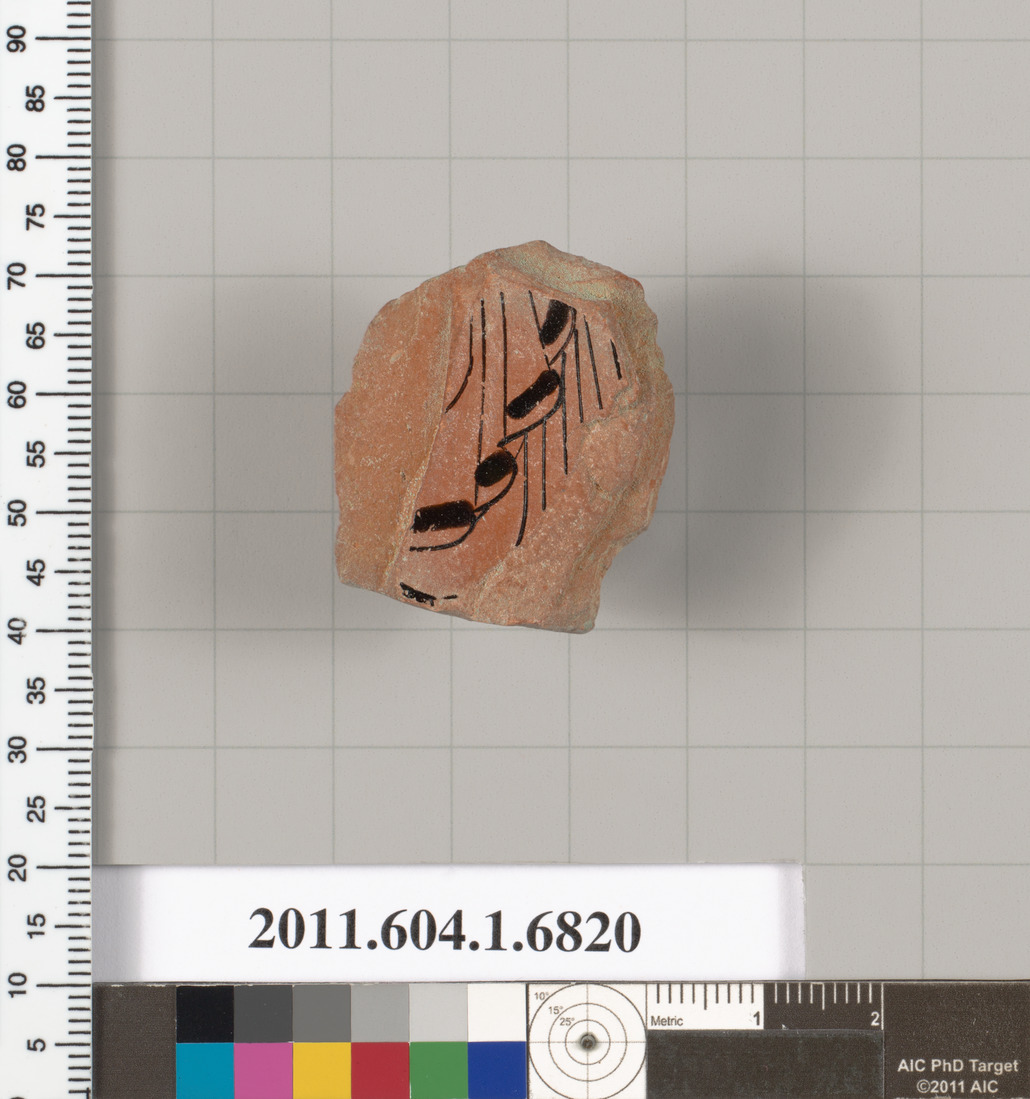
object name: kylix fragment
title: Terracotta fragment of a kylix (drinking cup)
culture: greek, attic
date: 490-470 BCE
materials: terracotta